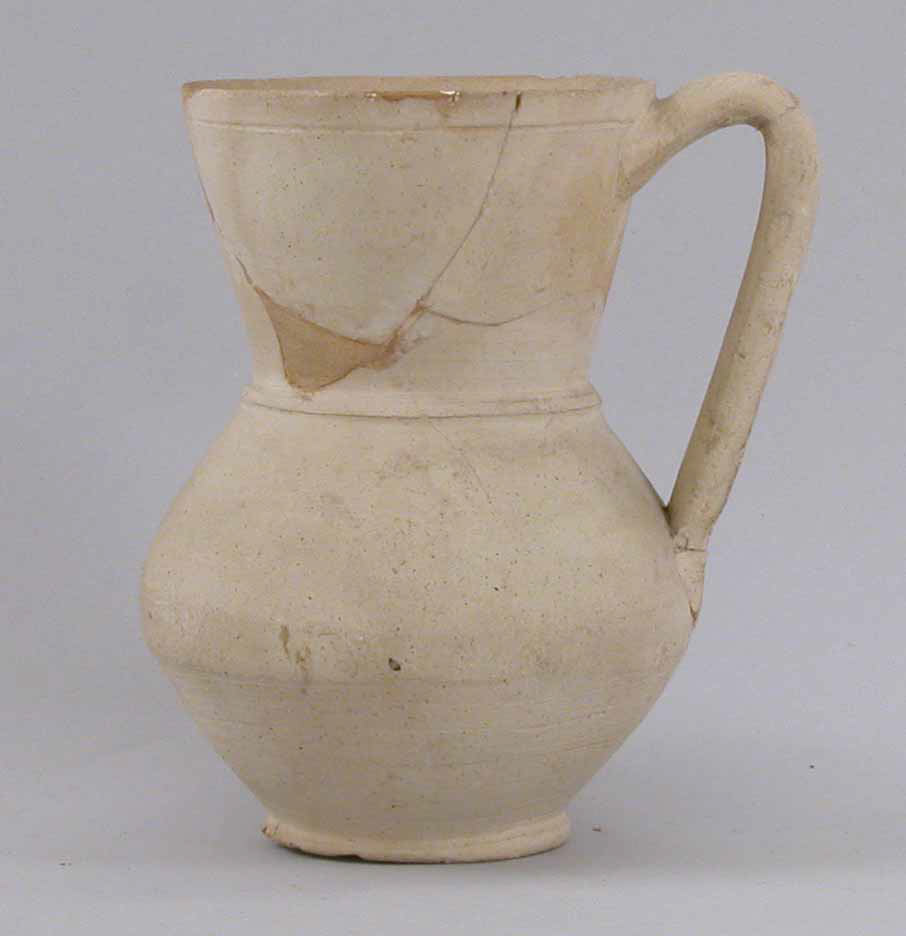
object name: ewer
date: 801-1000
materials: earthenware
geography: iran